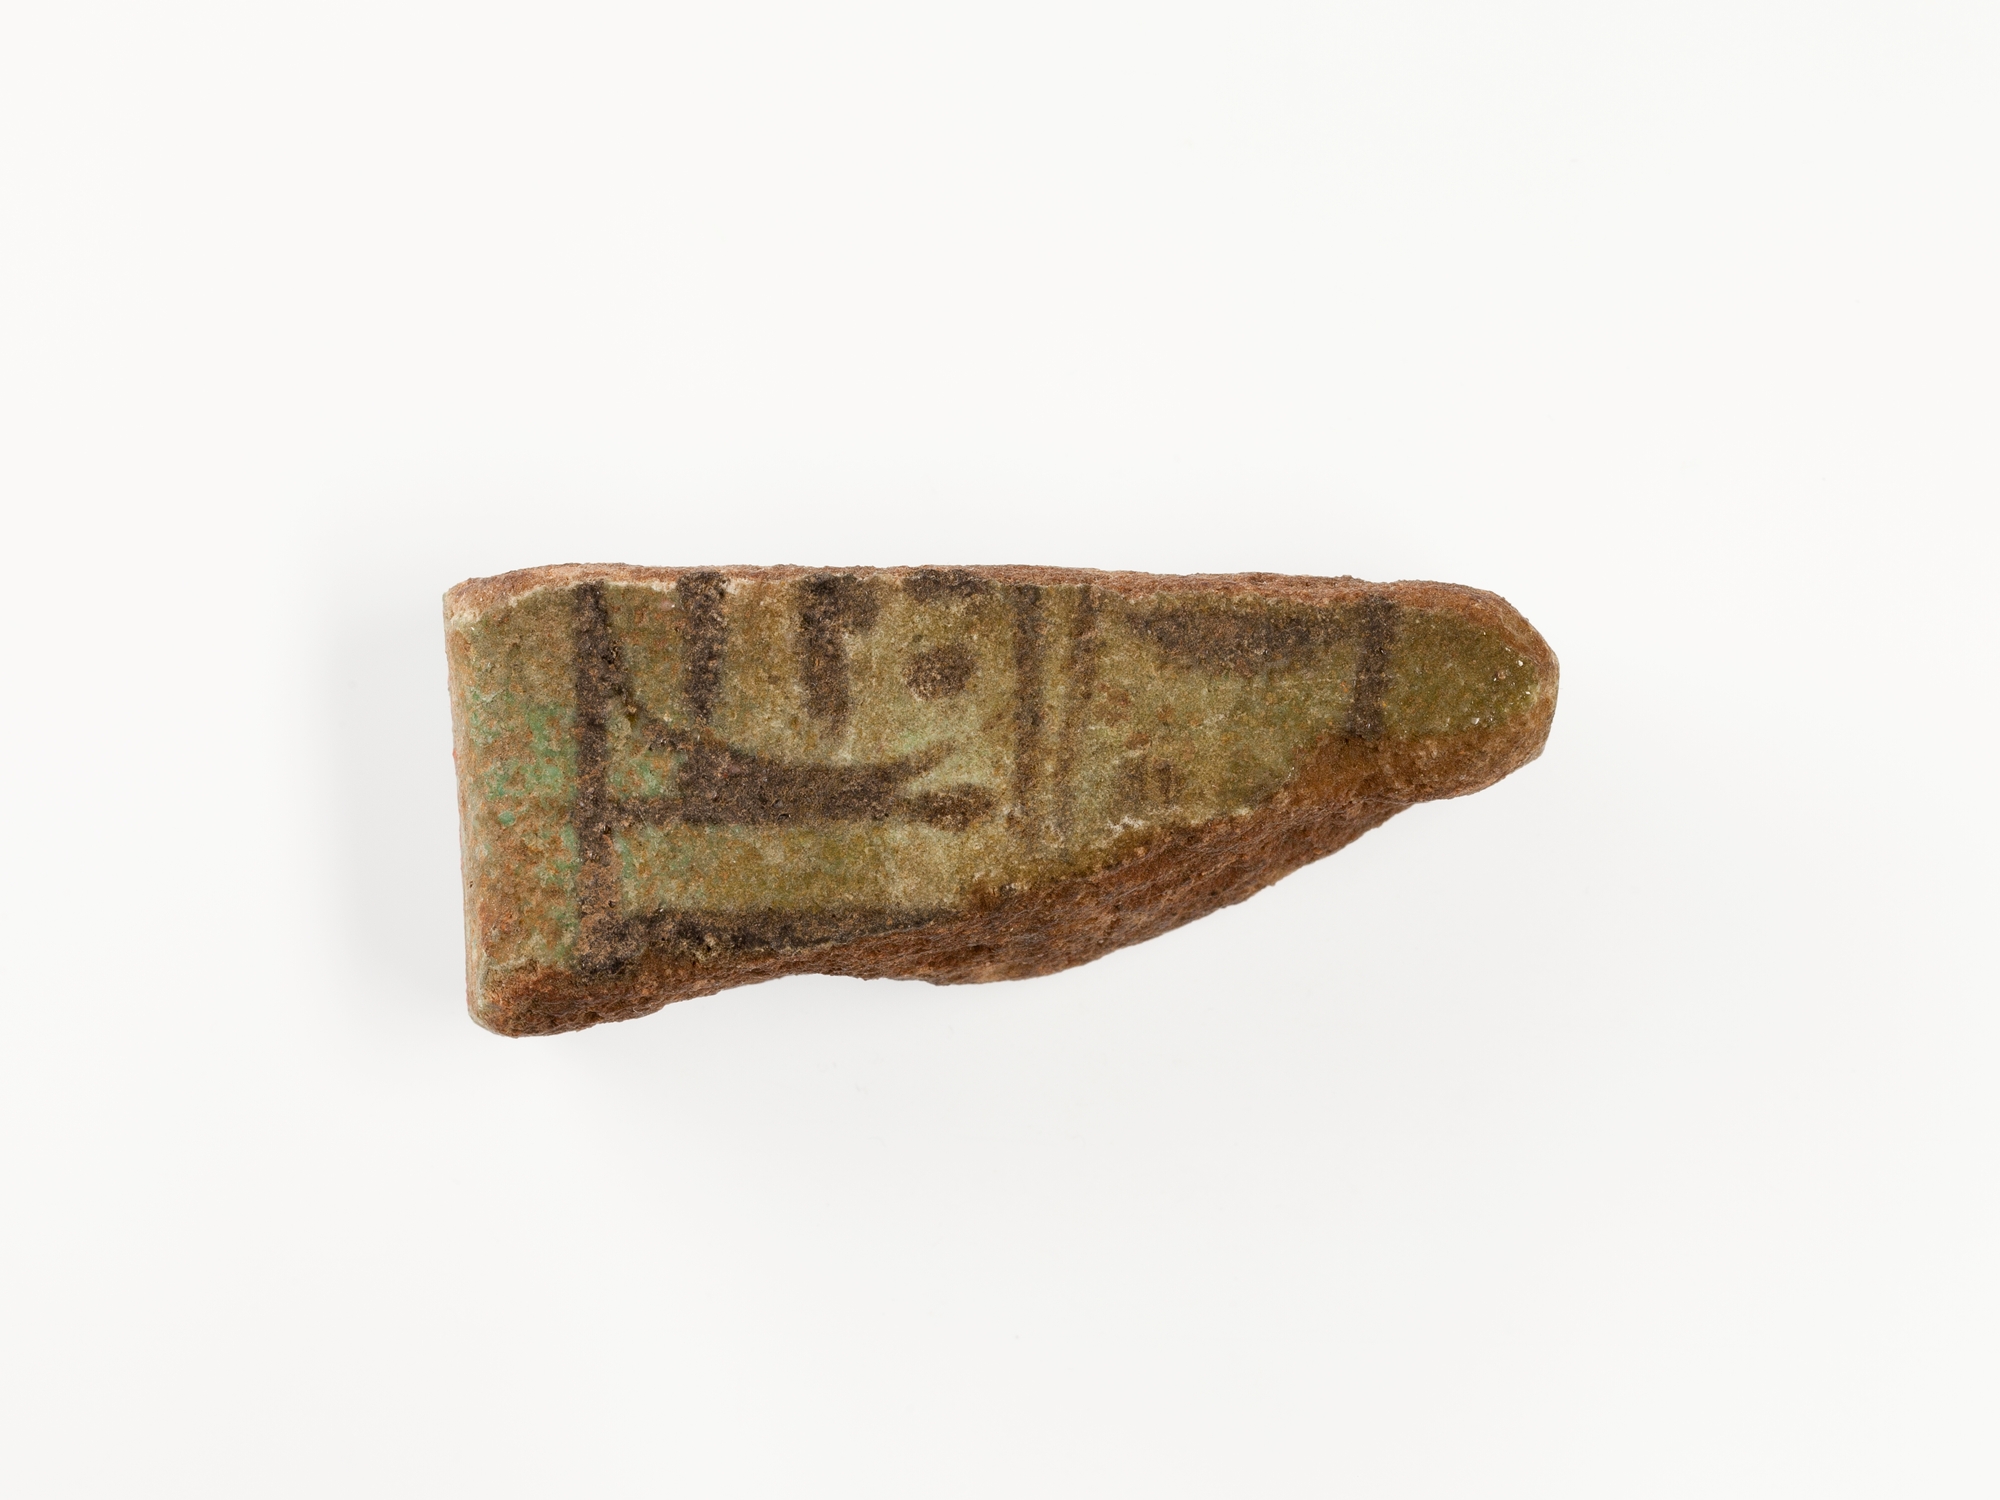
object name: votive tile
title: Fragment of a votive tile with cartouche of Seti II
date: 1200-1194 BCE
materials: faience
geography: egypt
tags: cartouches